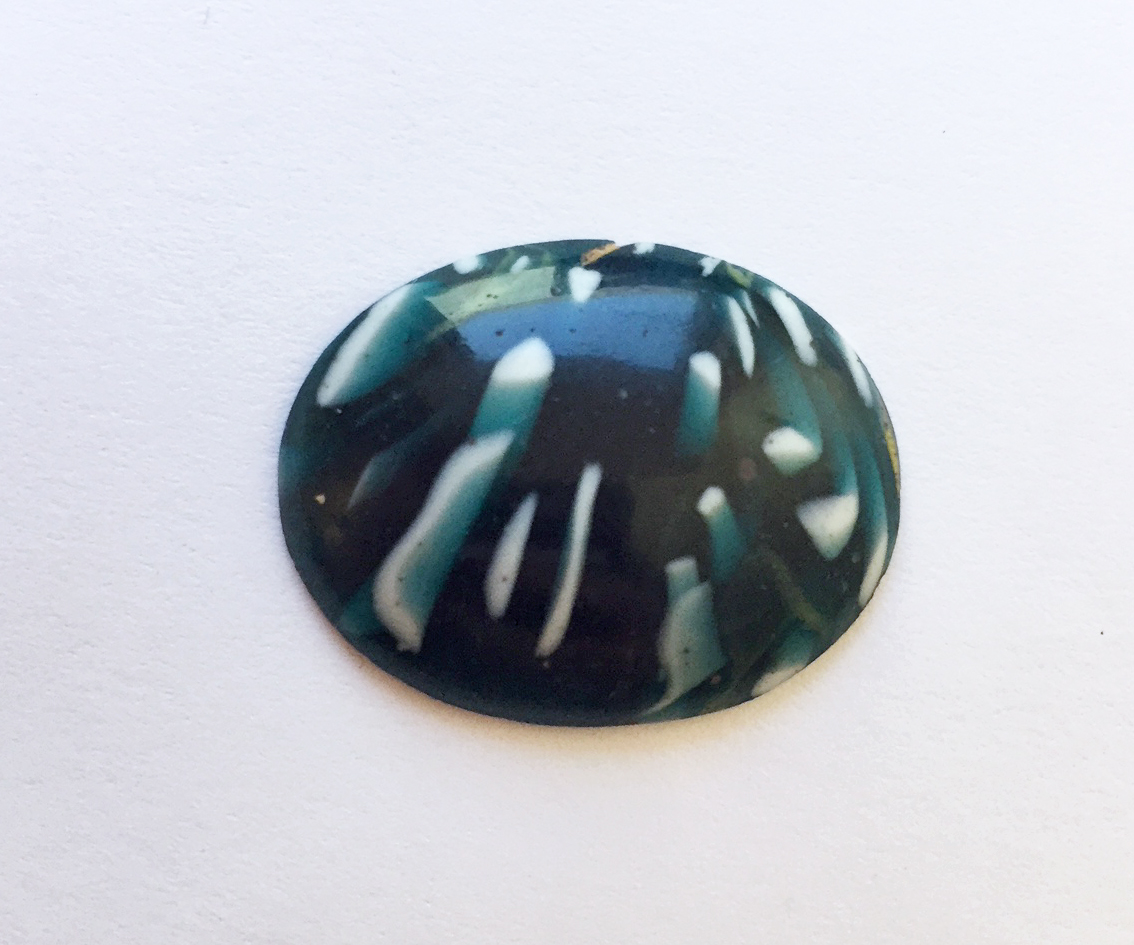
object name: mosaic glass fragment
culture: roman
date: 34 BCE-33 CE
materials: glass